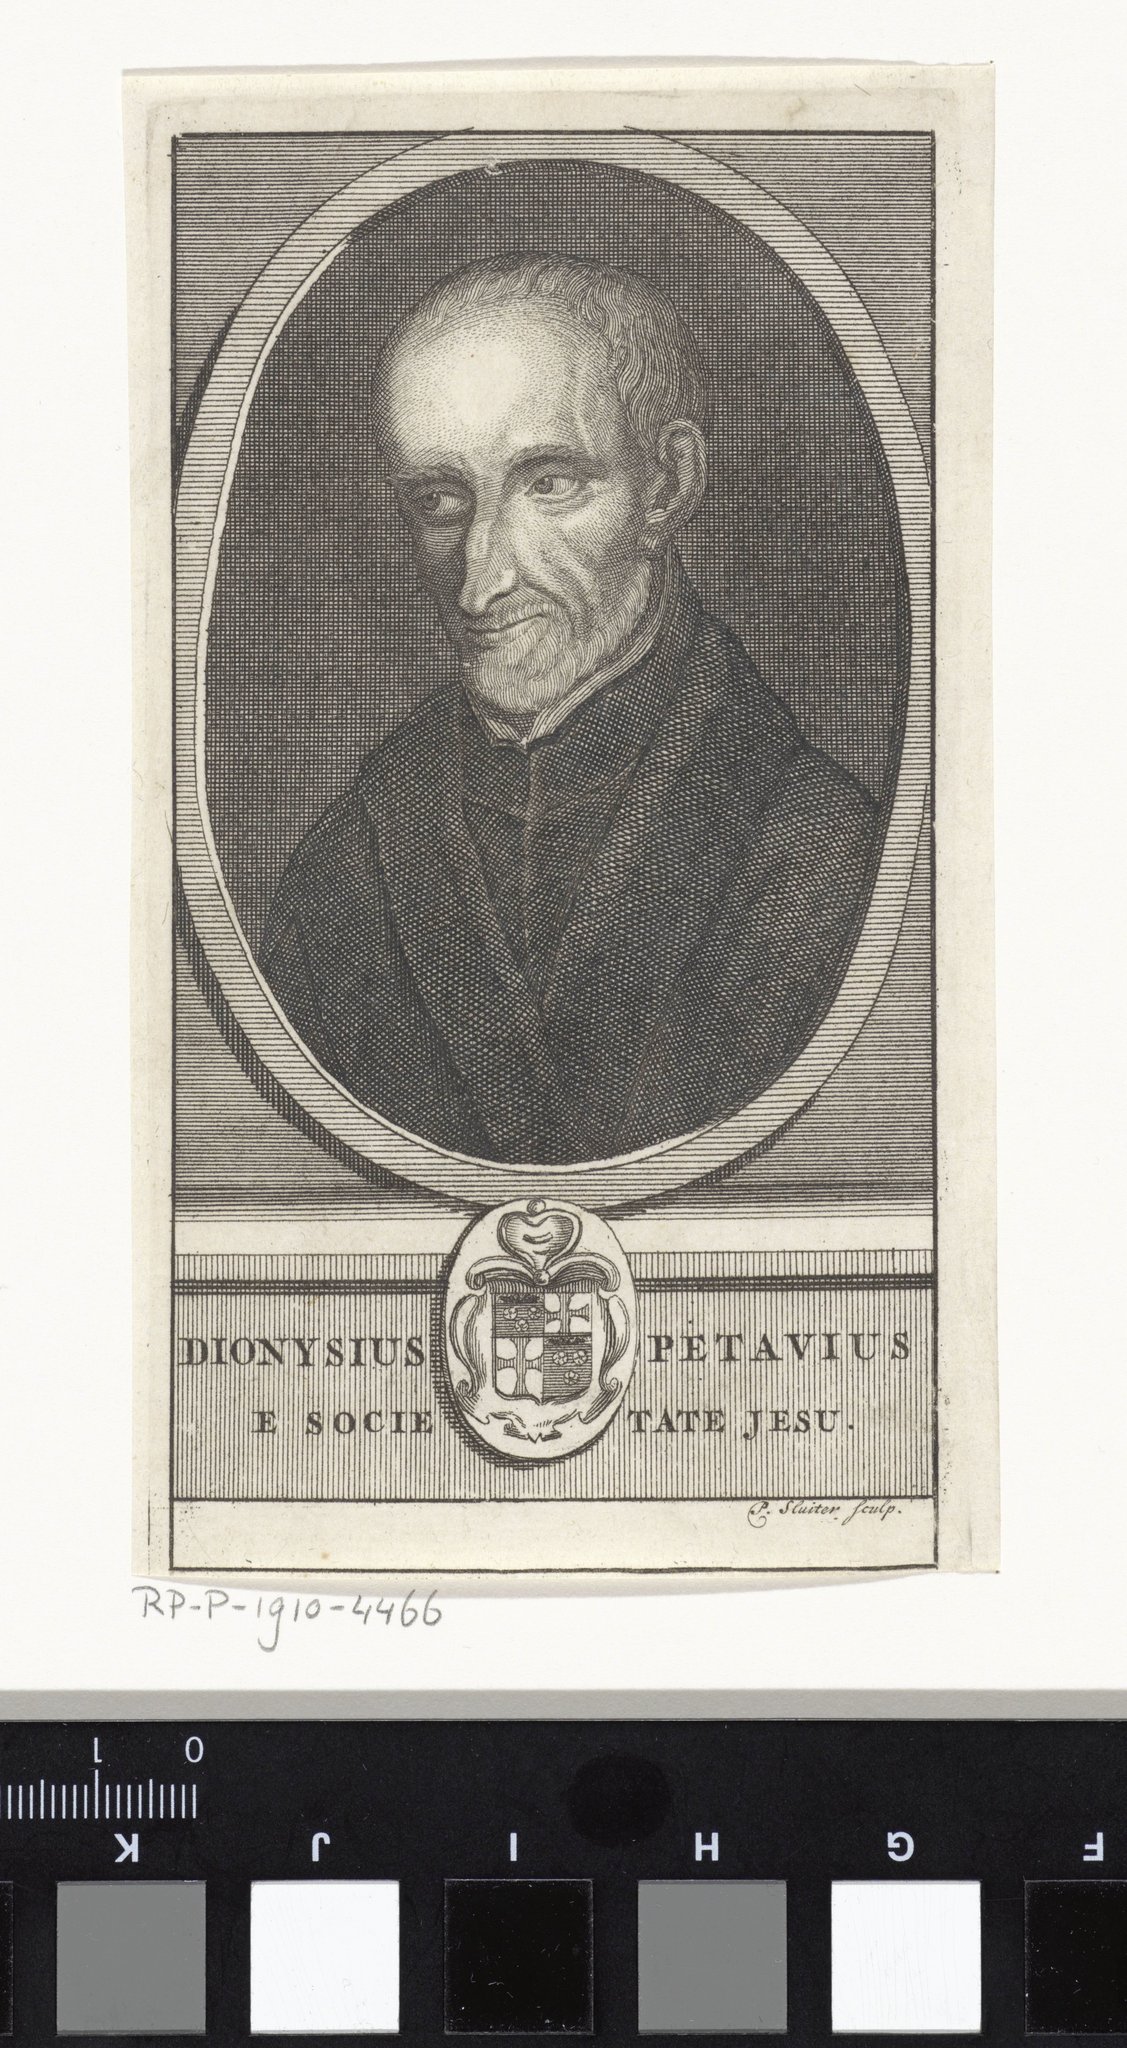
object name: print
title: Portret van Denis Pétau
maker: pieter sluyter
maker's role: print maker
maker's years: 1675-1733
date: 1696-1713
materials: paper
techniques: engraving, etching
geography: amsterdam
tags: paris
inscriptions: collector's mark: Lugt 2228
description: Portret van de jezuïet Denis Pétau. Onder het portret zijn wapenschild.